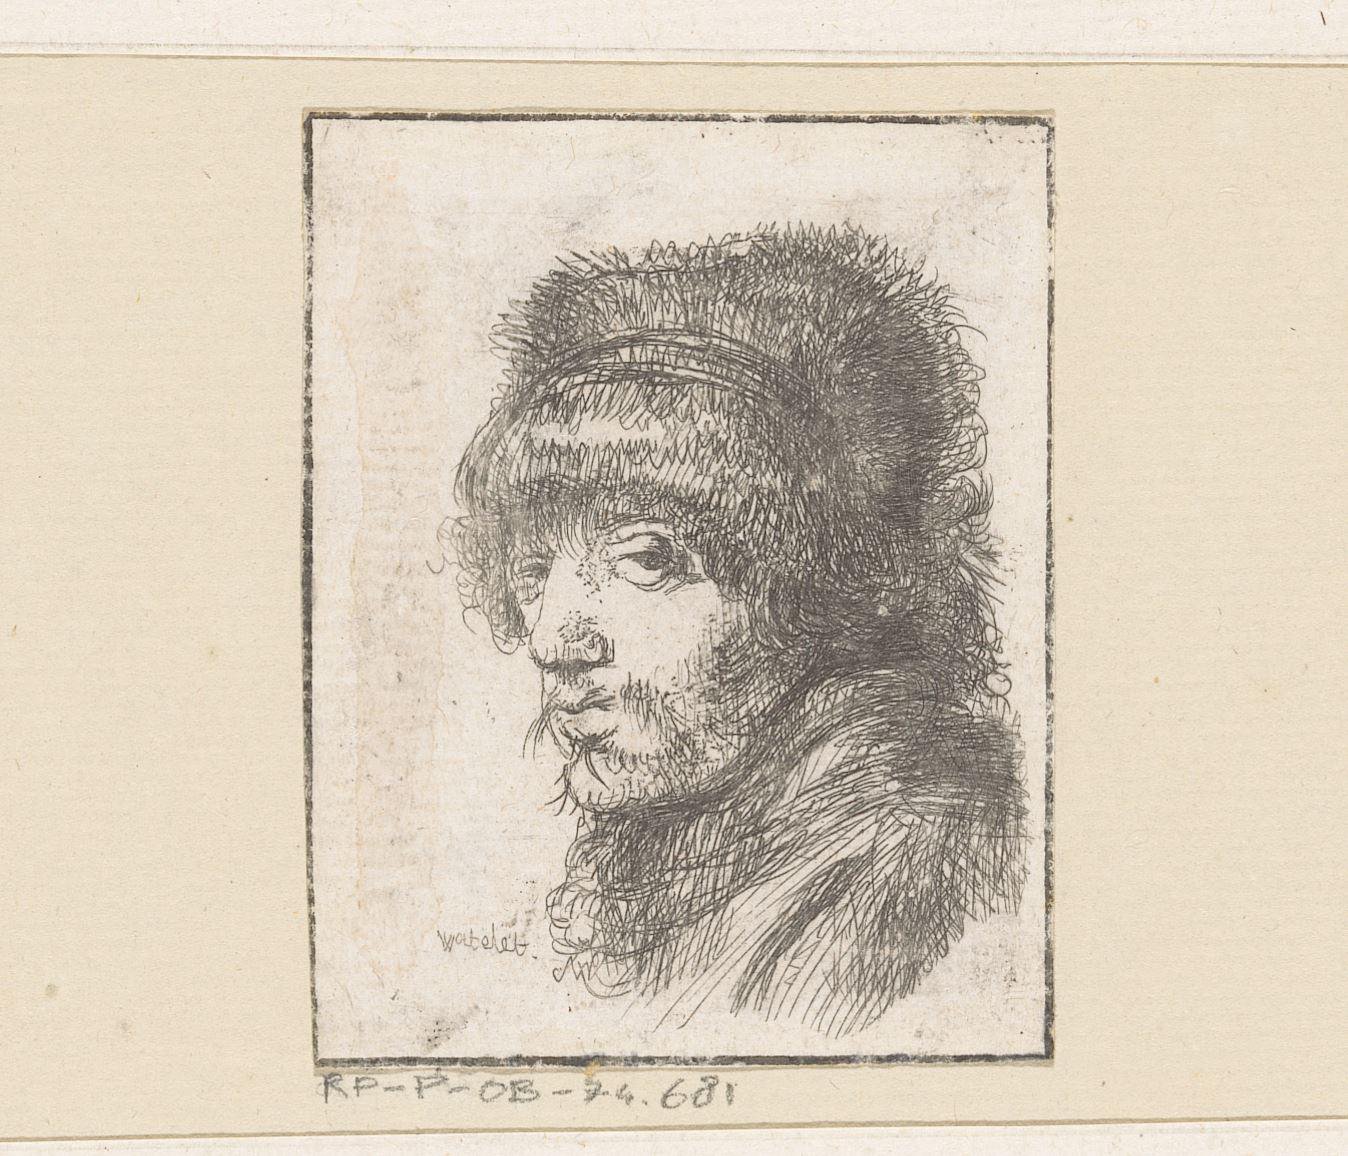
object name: print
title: Kop van man met bontmuts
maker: claude henri watelet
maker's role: print maker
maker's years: 1718-1786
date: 1728-1786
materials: paper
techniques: etching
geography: france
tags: head (human), head-gear (with name)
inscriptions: collector's mark: Lugt 240